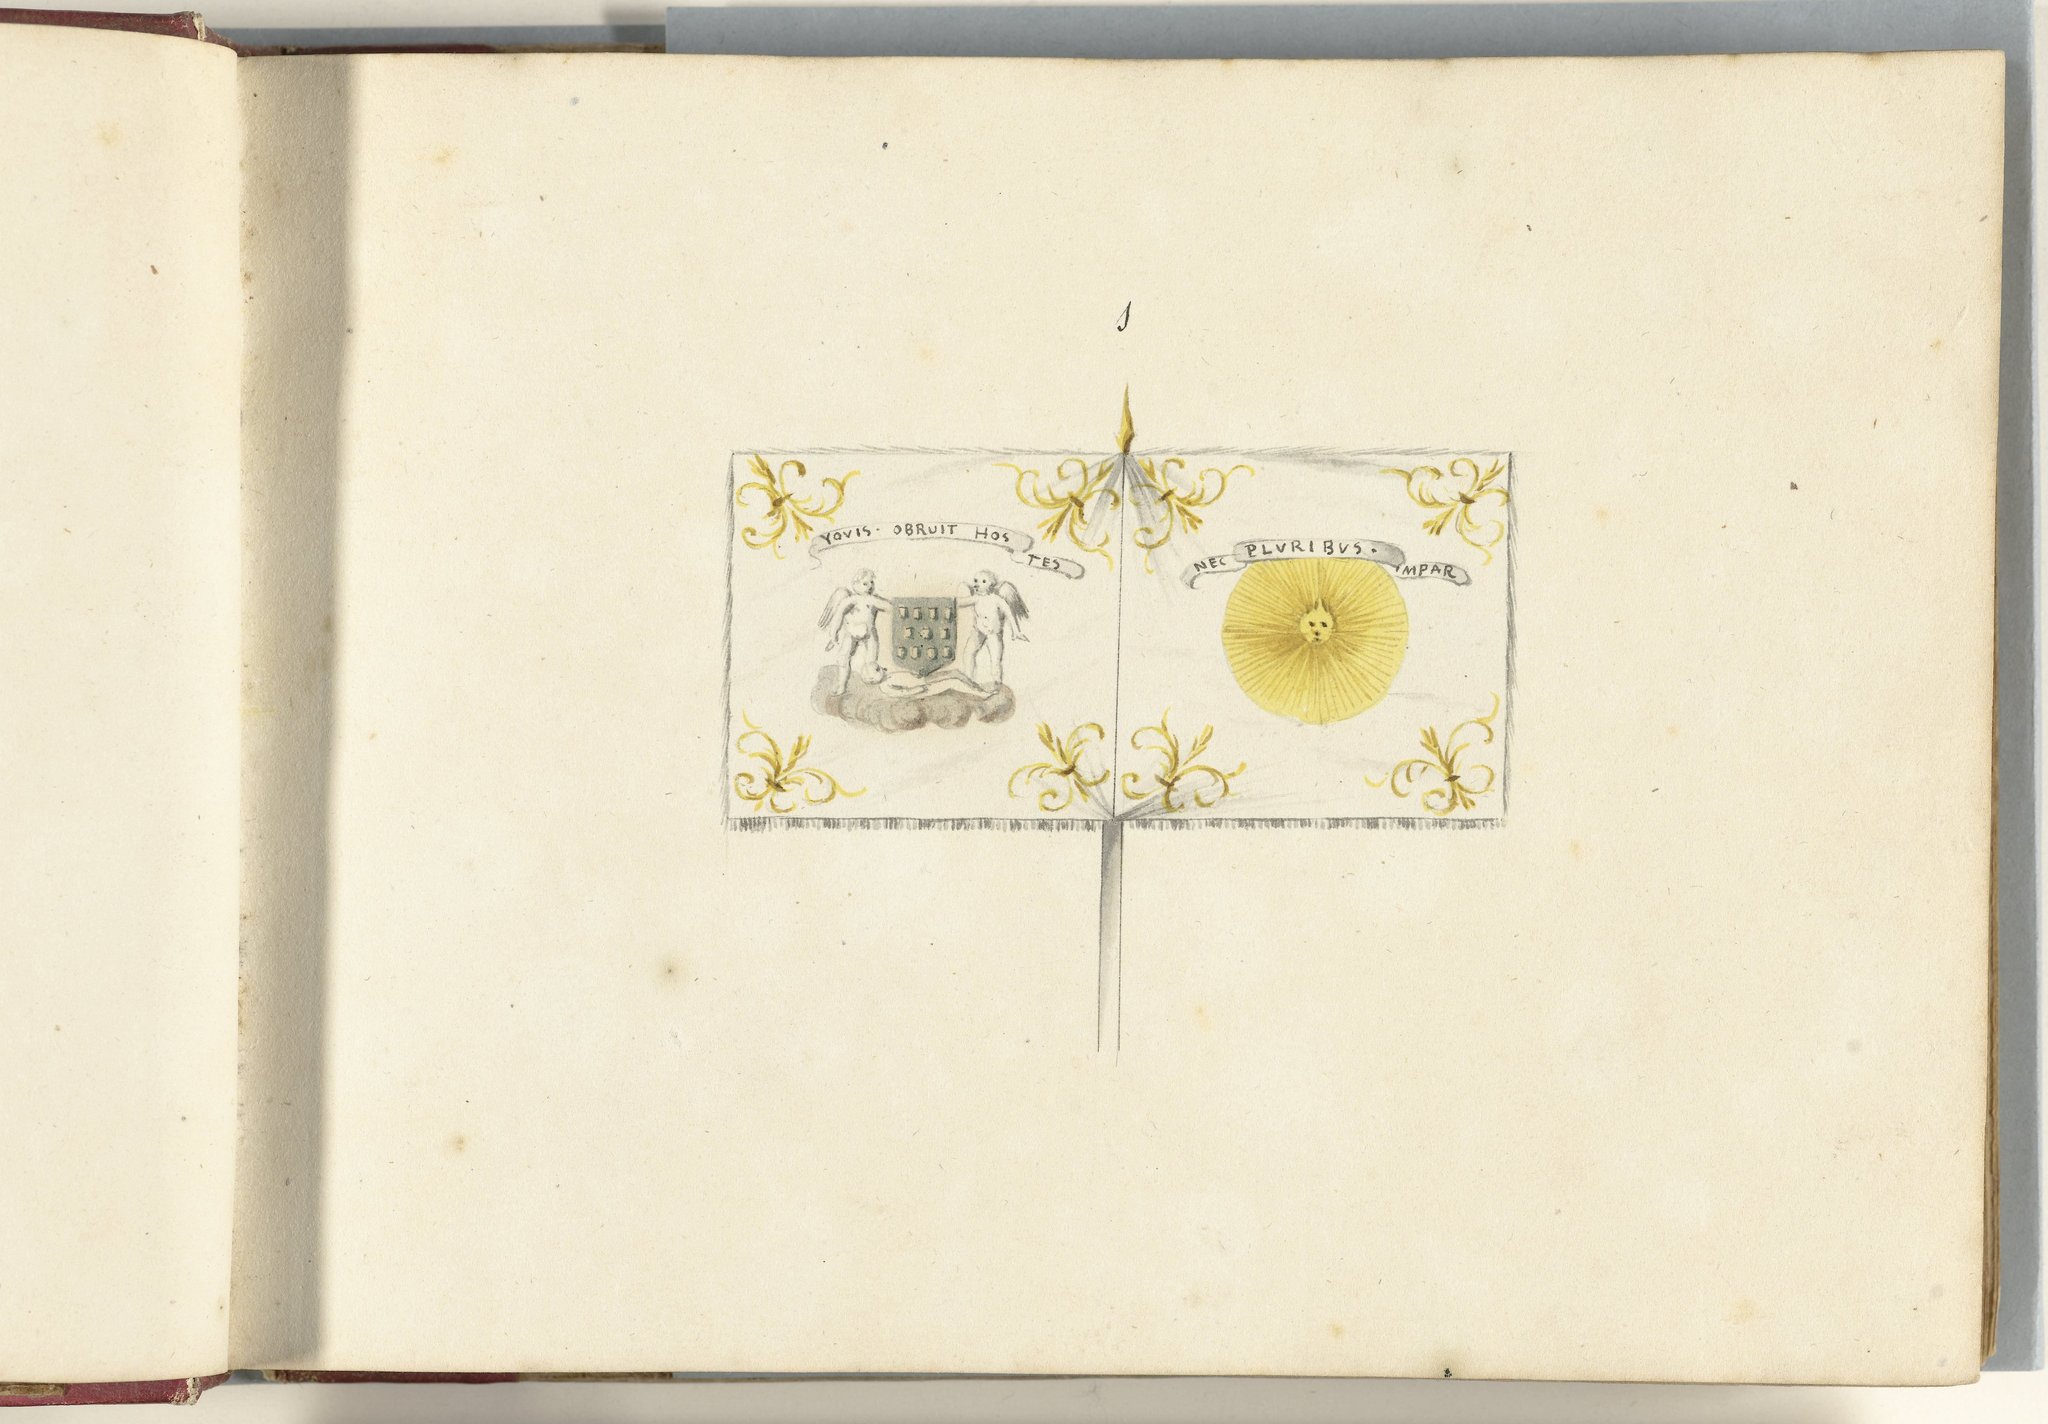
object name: drawing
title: Frans standaard veroverd in de slag bij Spierbach, 1703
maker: Anonymous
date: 1713-1720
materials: paper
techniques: drawing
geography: northern netherlands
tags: (military) flags and standards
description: Frans standaard veroverd in de slag bij Spierbach, 1703. In het boek met tekeningen van Franse vaandels, standaarden en pauken, veroverd tijdens de Spaanse Successieoorlog (1701-1713).